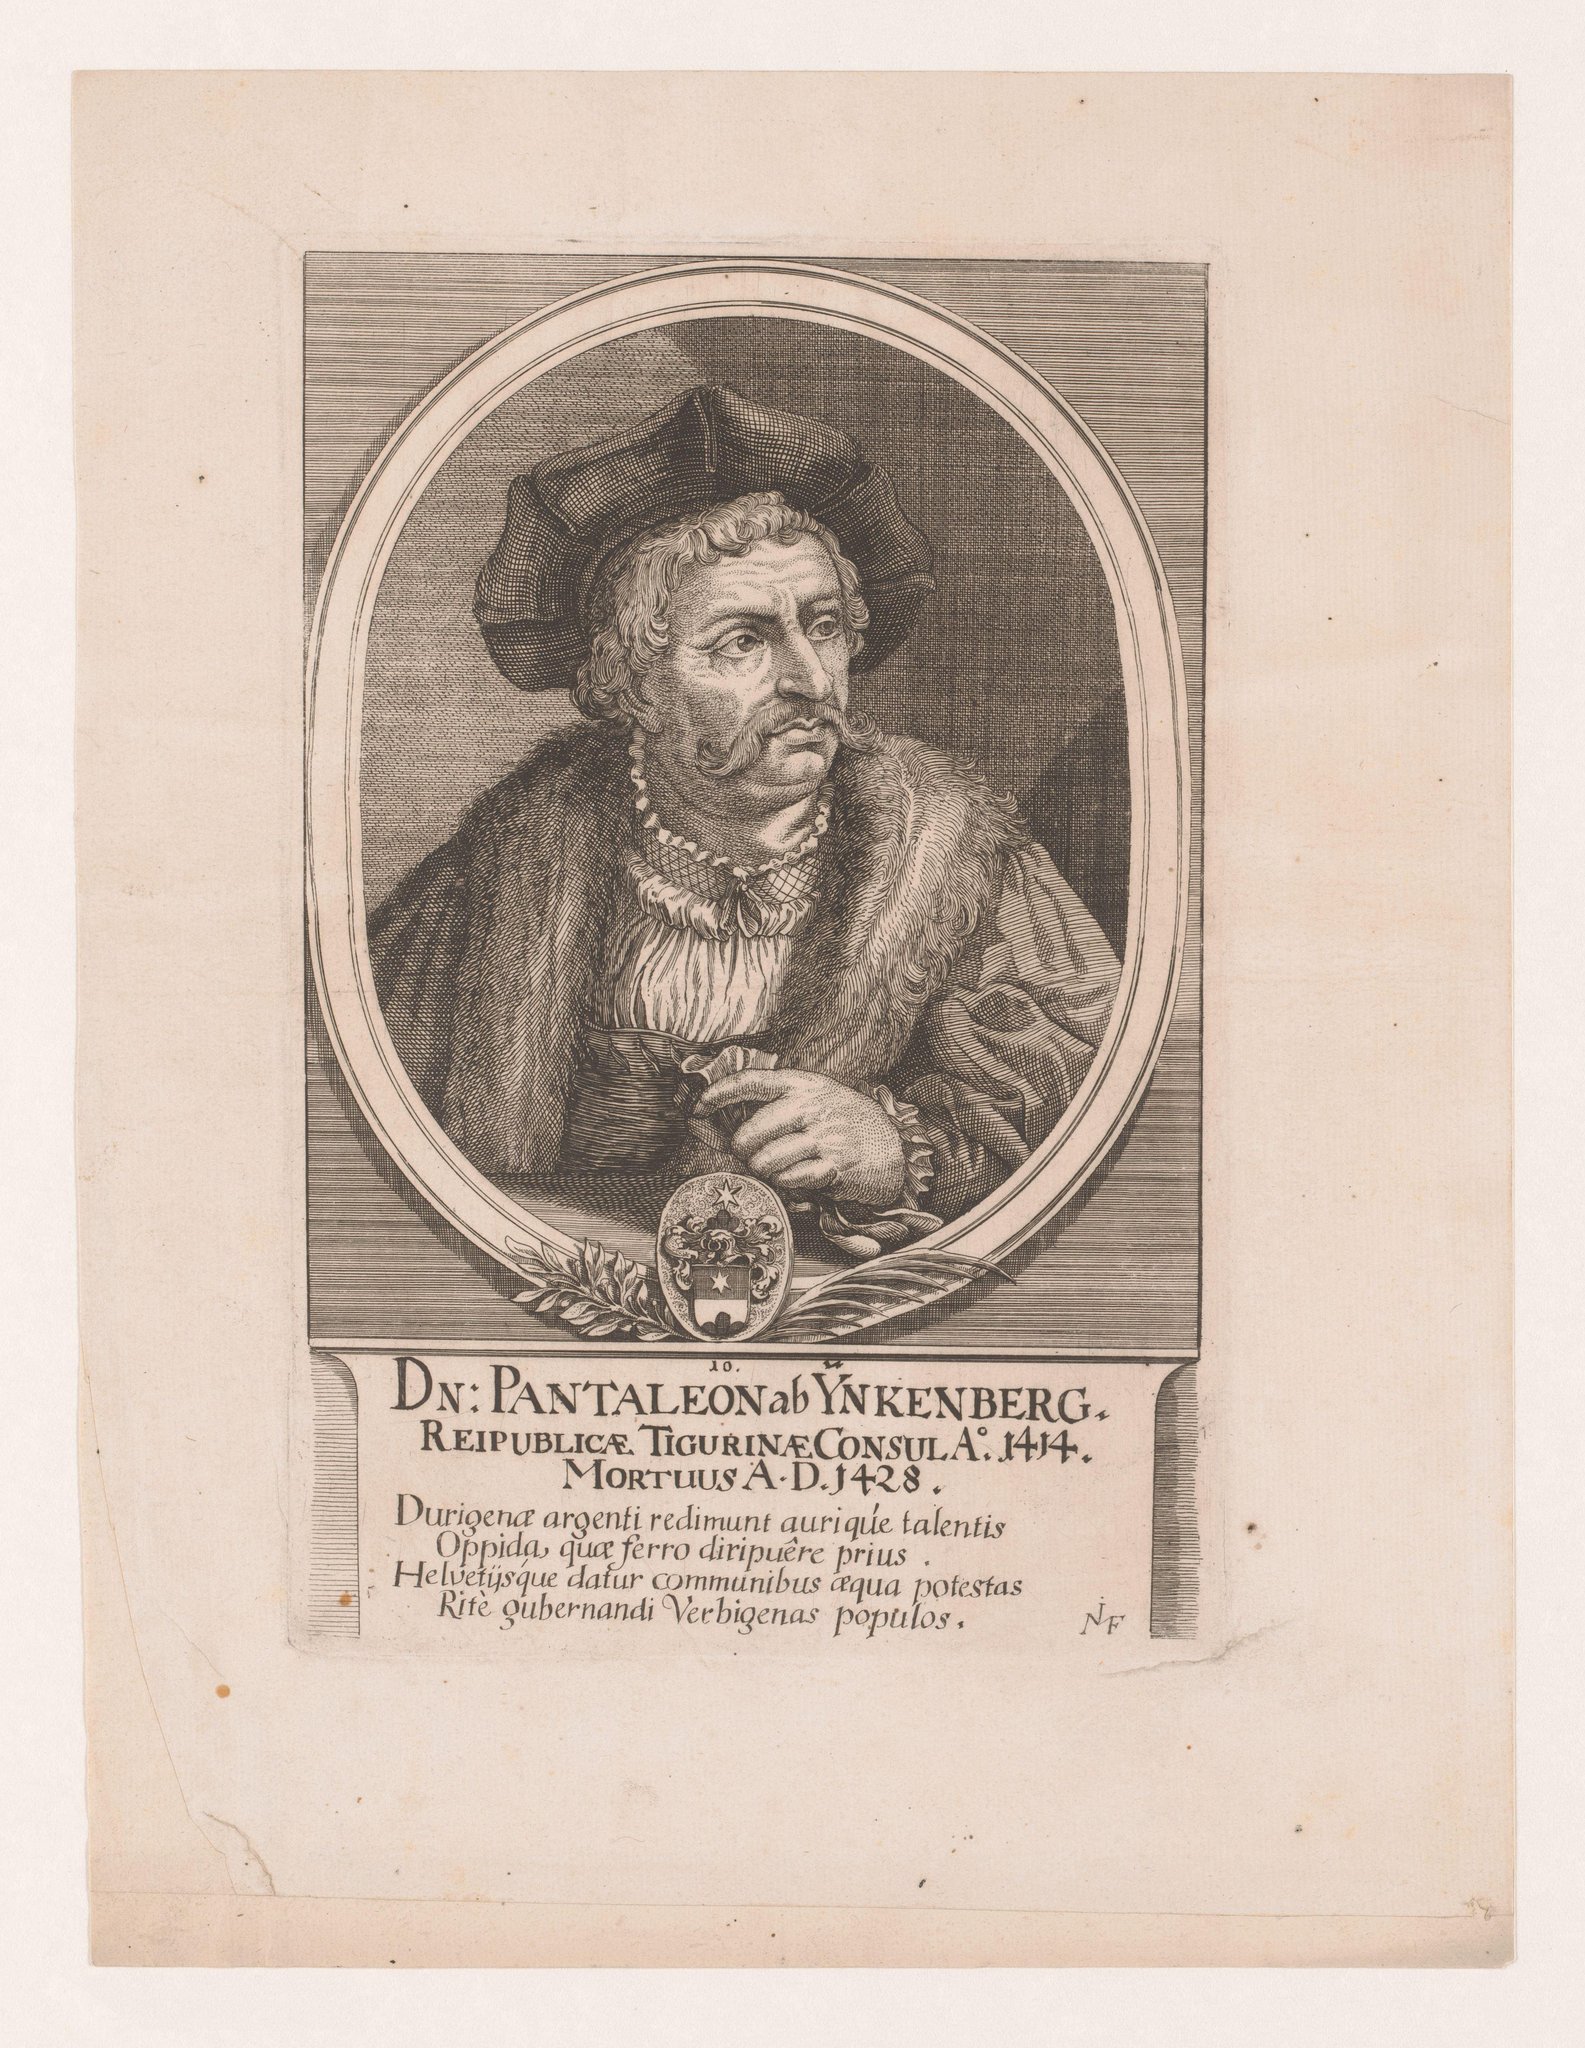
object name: print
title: Portretten van burgemeesters van Zürich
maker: johannes meyer (ii)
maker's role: print maker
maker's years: 1655-1712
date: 1665-1712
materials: paper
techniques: engraving, etching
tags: mayor, burgomaster, gloves, mittens, etc., historical persons, armorial bearing, heraldry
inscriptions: collector's mark: Lugt 2228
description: Onderaan de ovale omlijsting genummerd: 10.